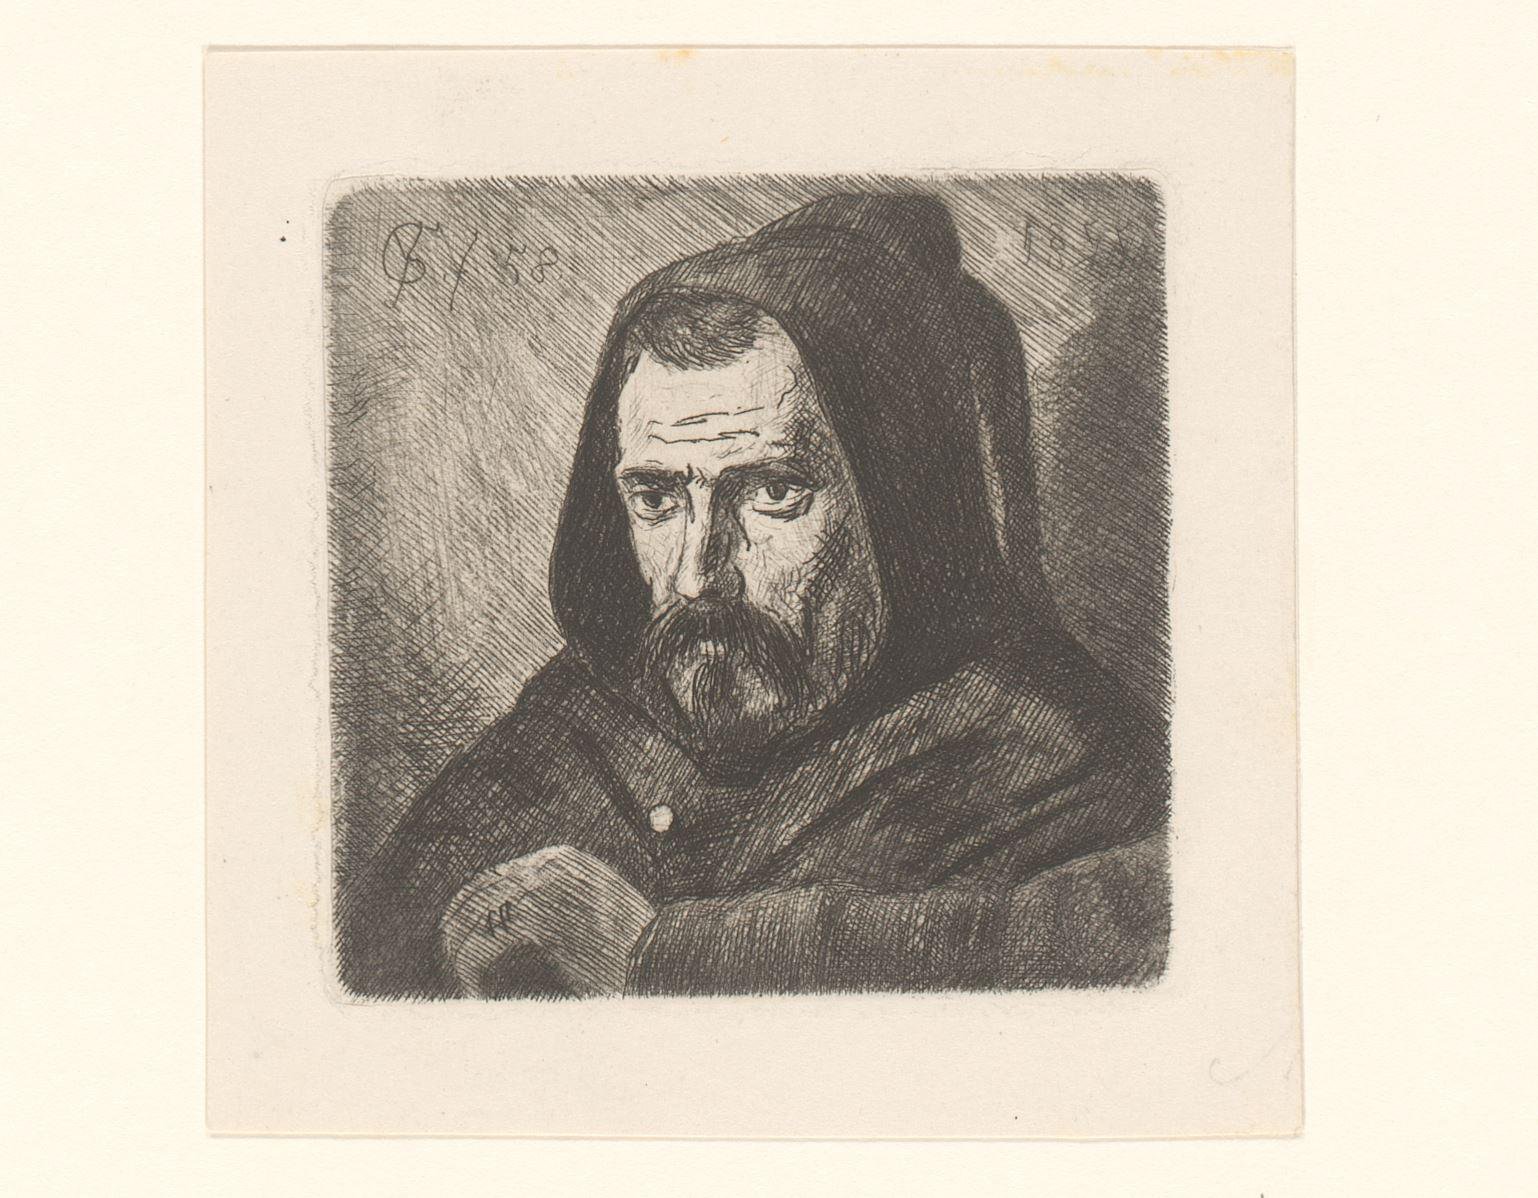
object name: print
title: Buste van een monnik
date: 1858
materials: paper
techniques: etching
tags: monk(s), friar(s)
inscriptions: collector's mark: Lugt 2228